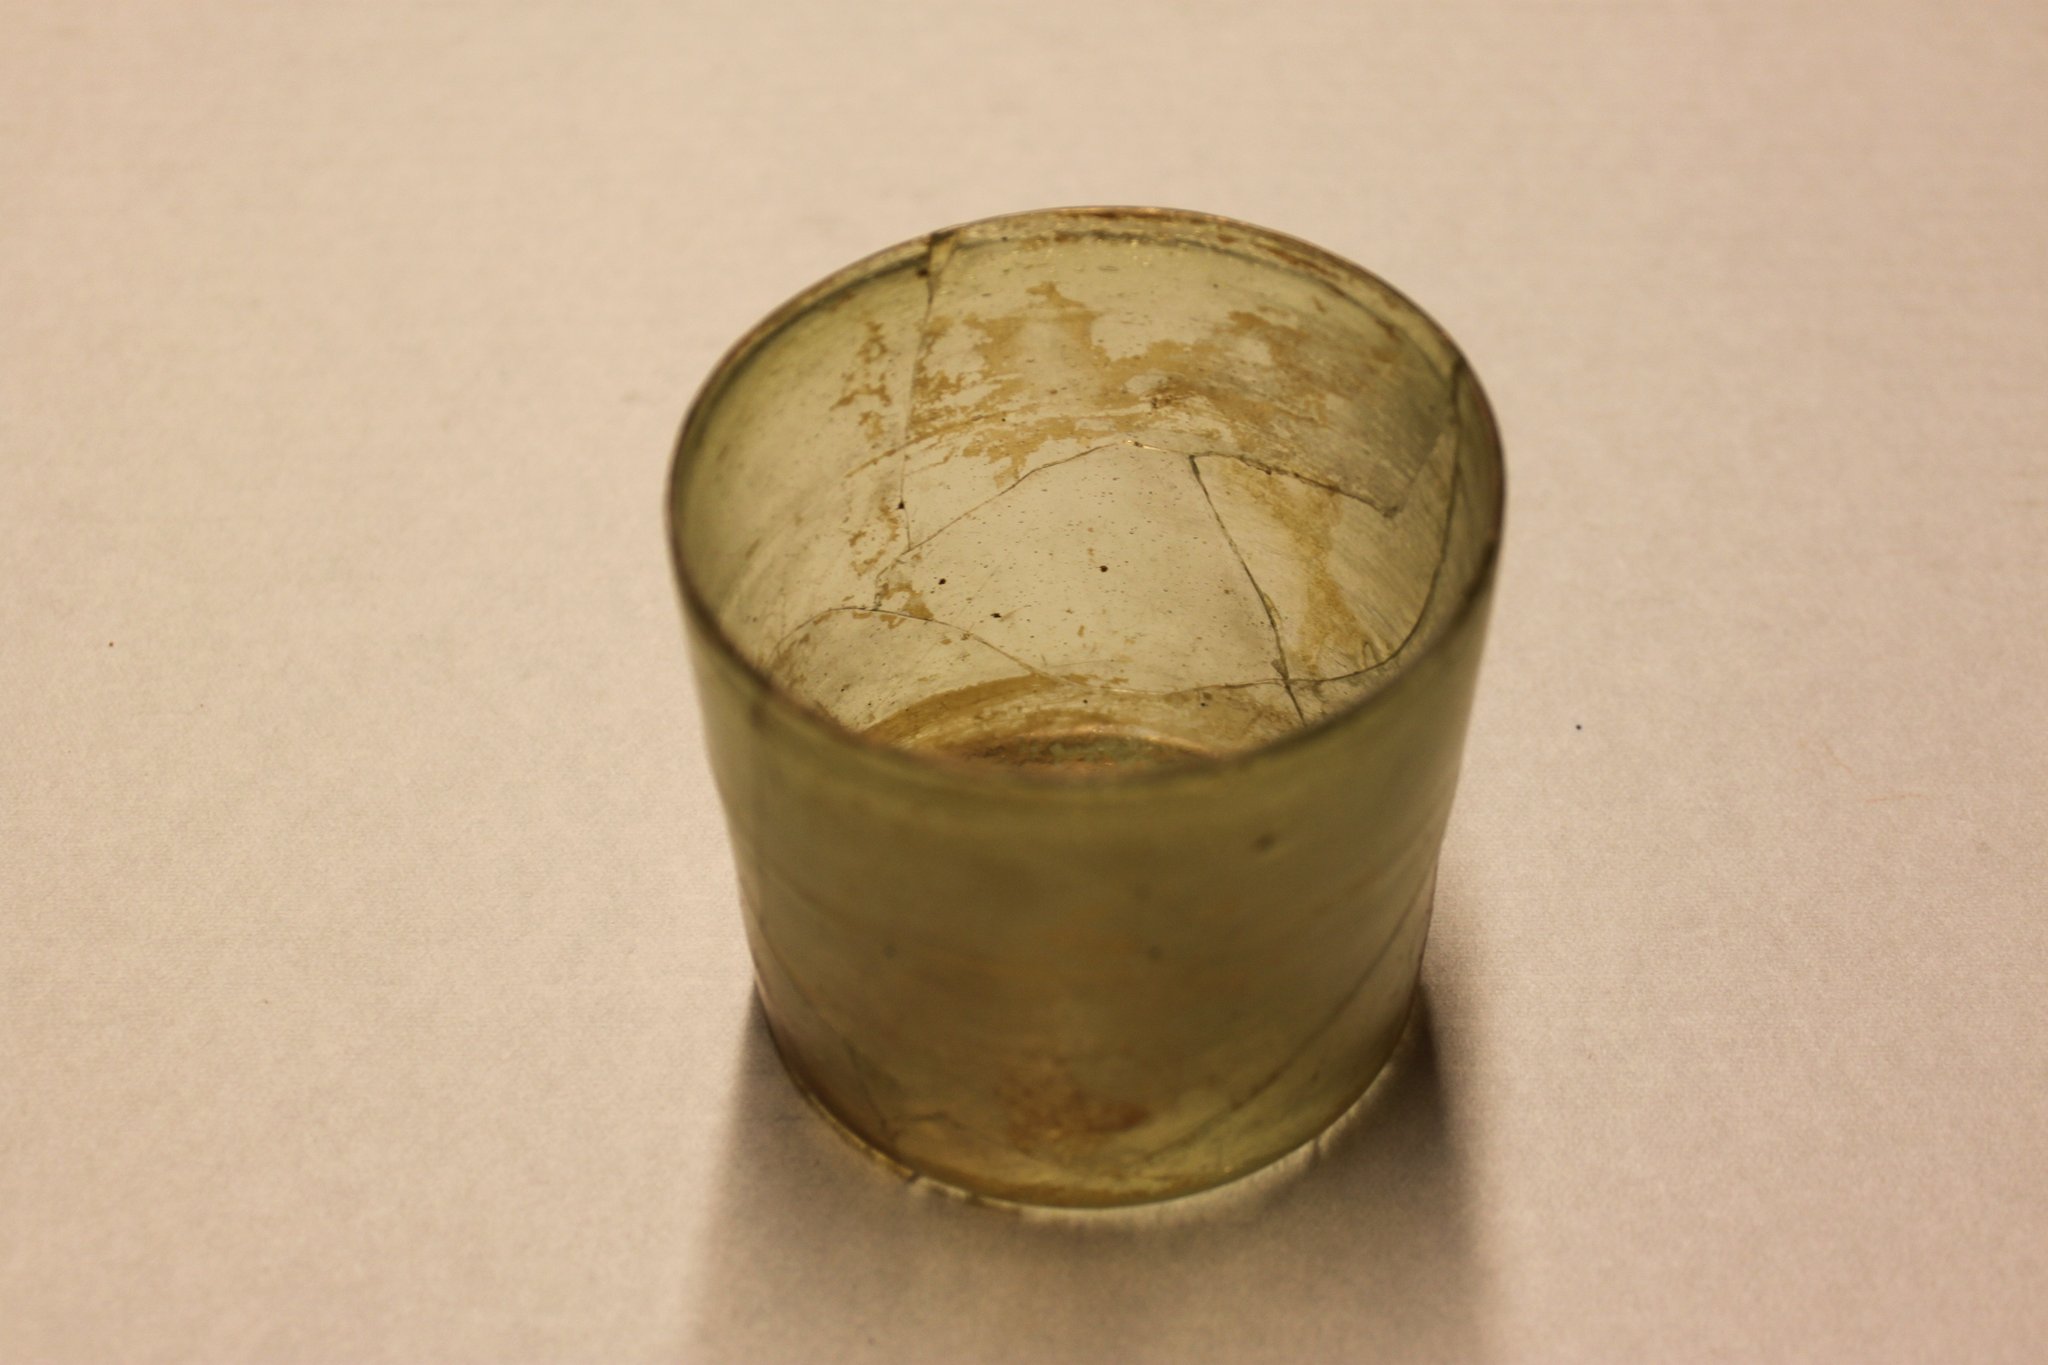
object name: tumbler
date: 901-1000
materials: glass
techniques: cutting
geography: iran